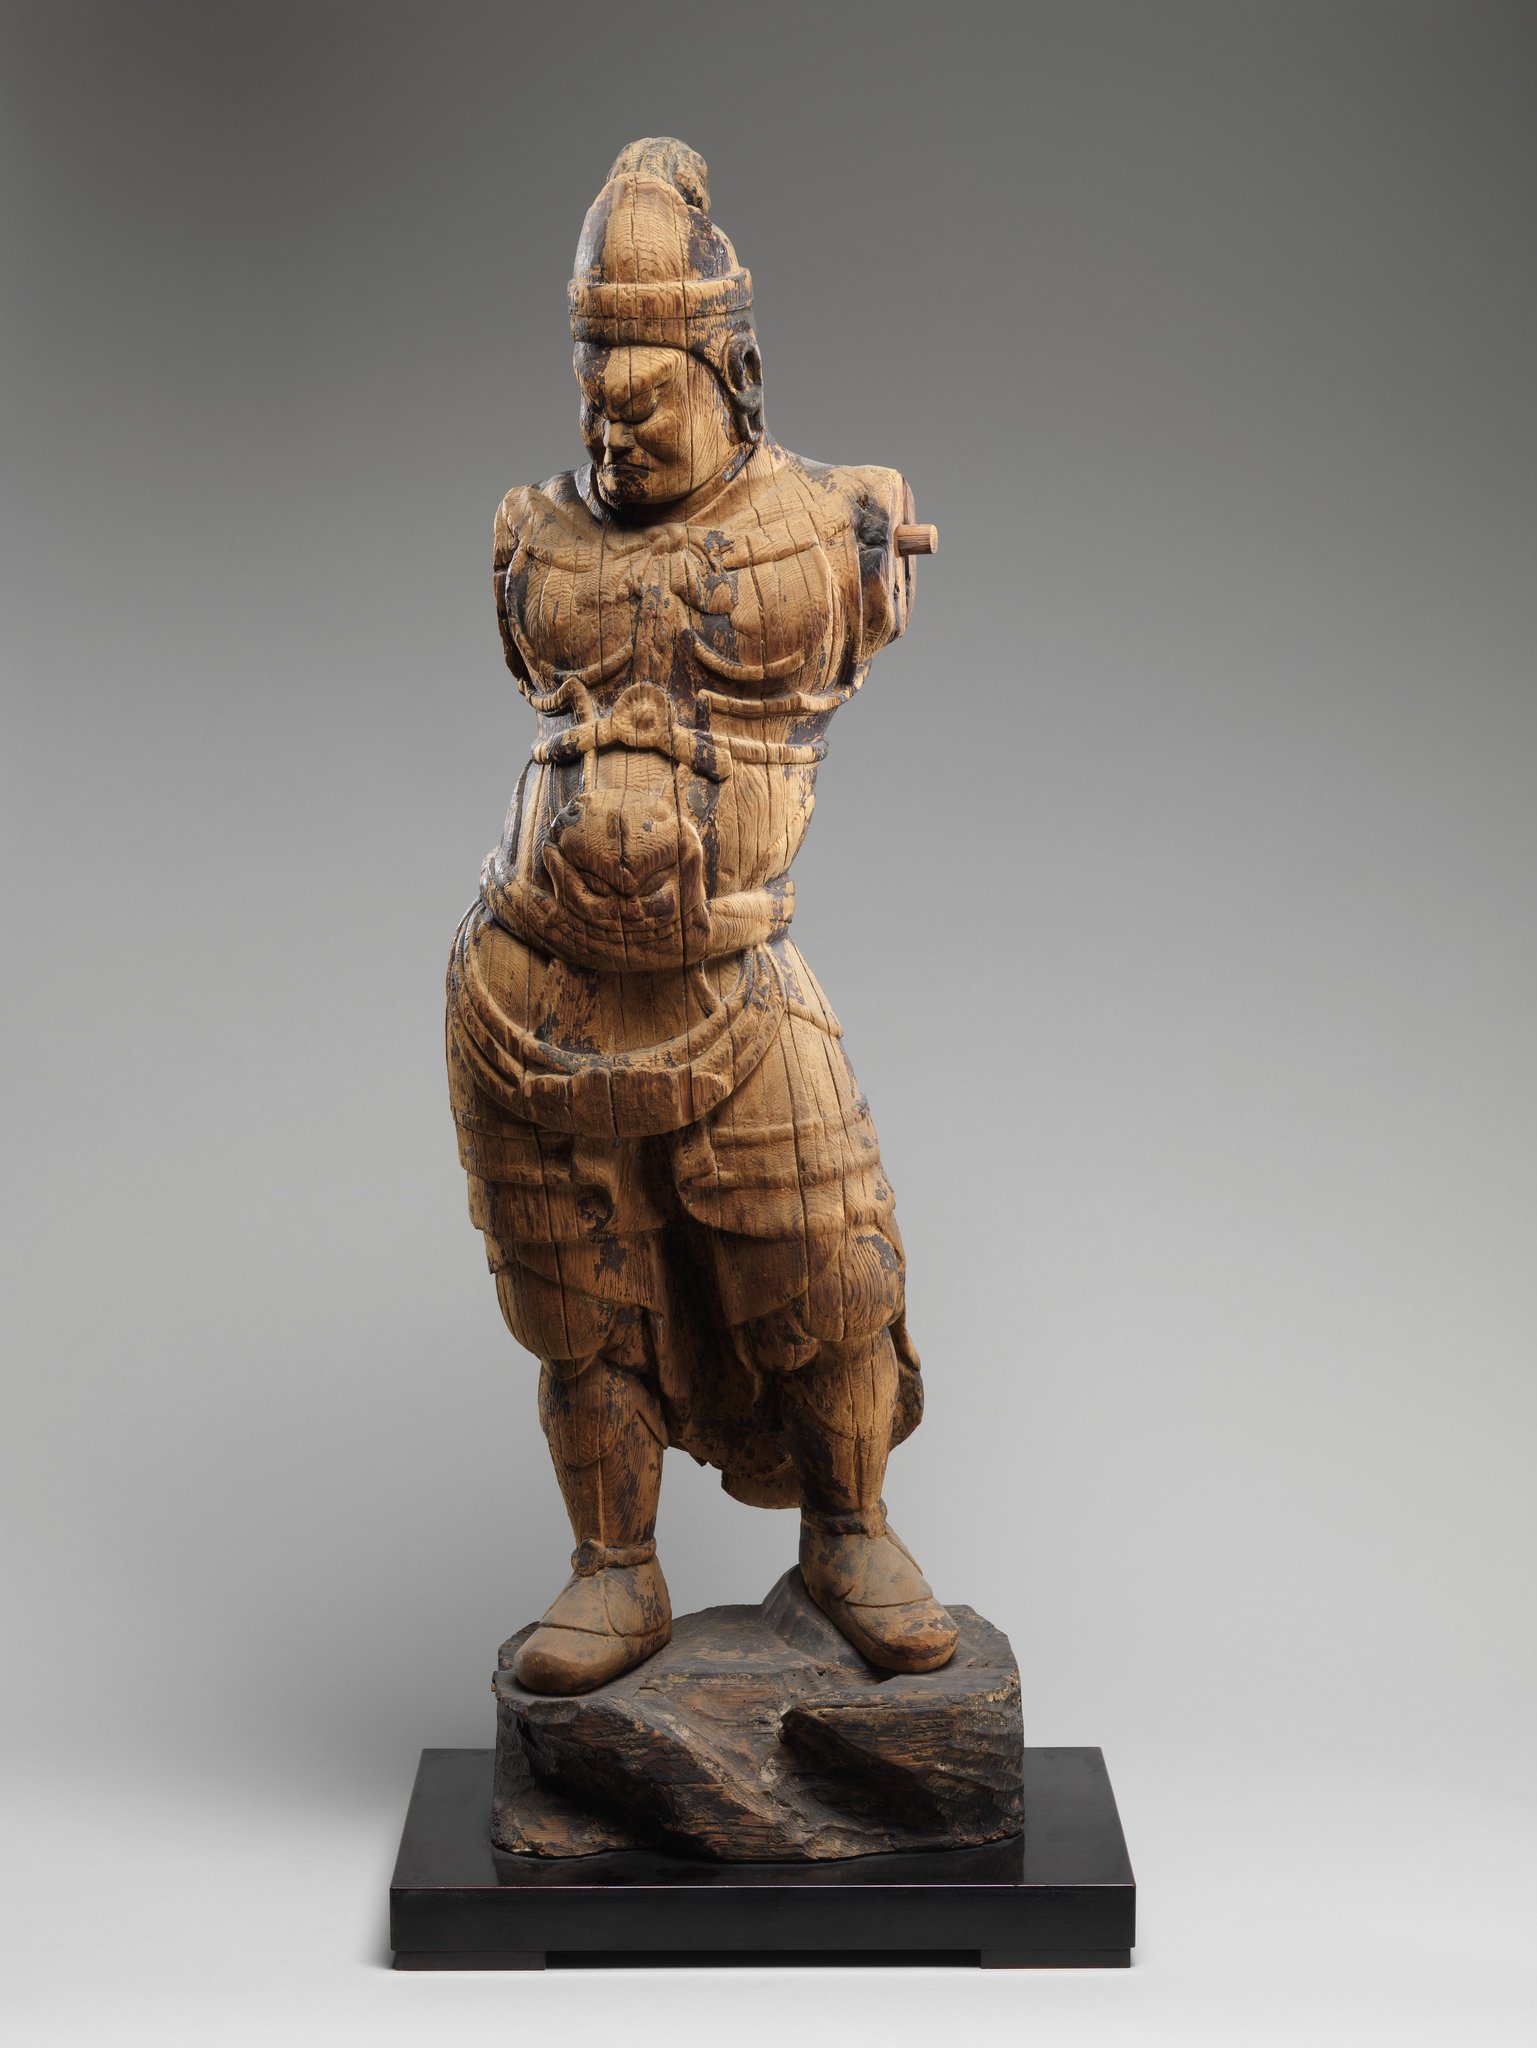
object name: figure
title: One of the Four Heavenly Kings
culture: japanese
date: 1101-1200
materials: wood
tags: men,buddhism